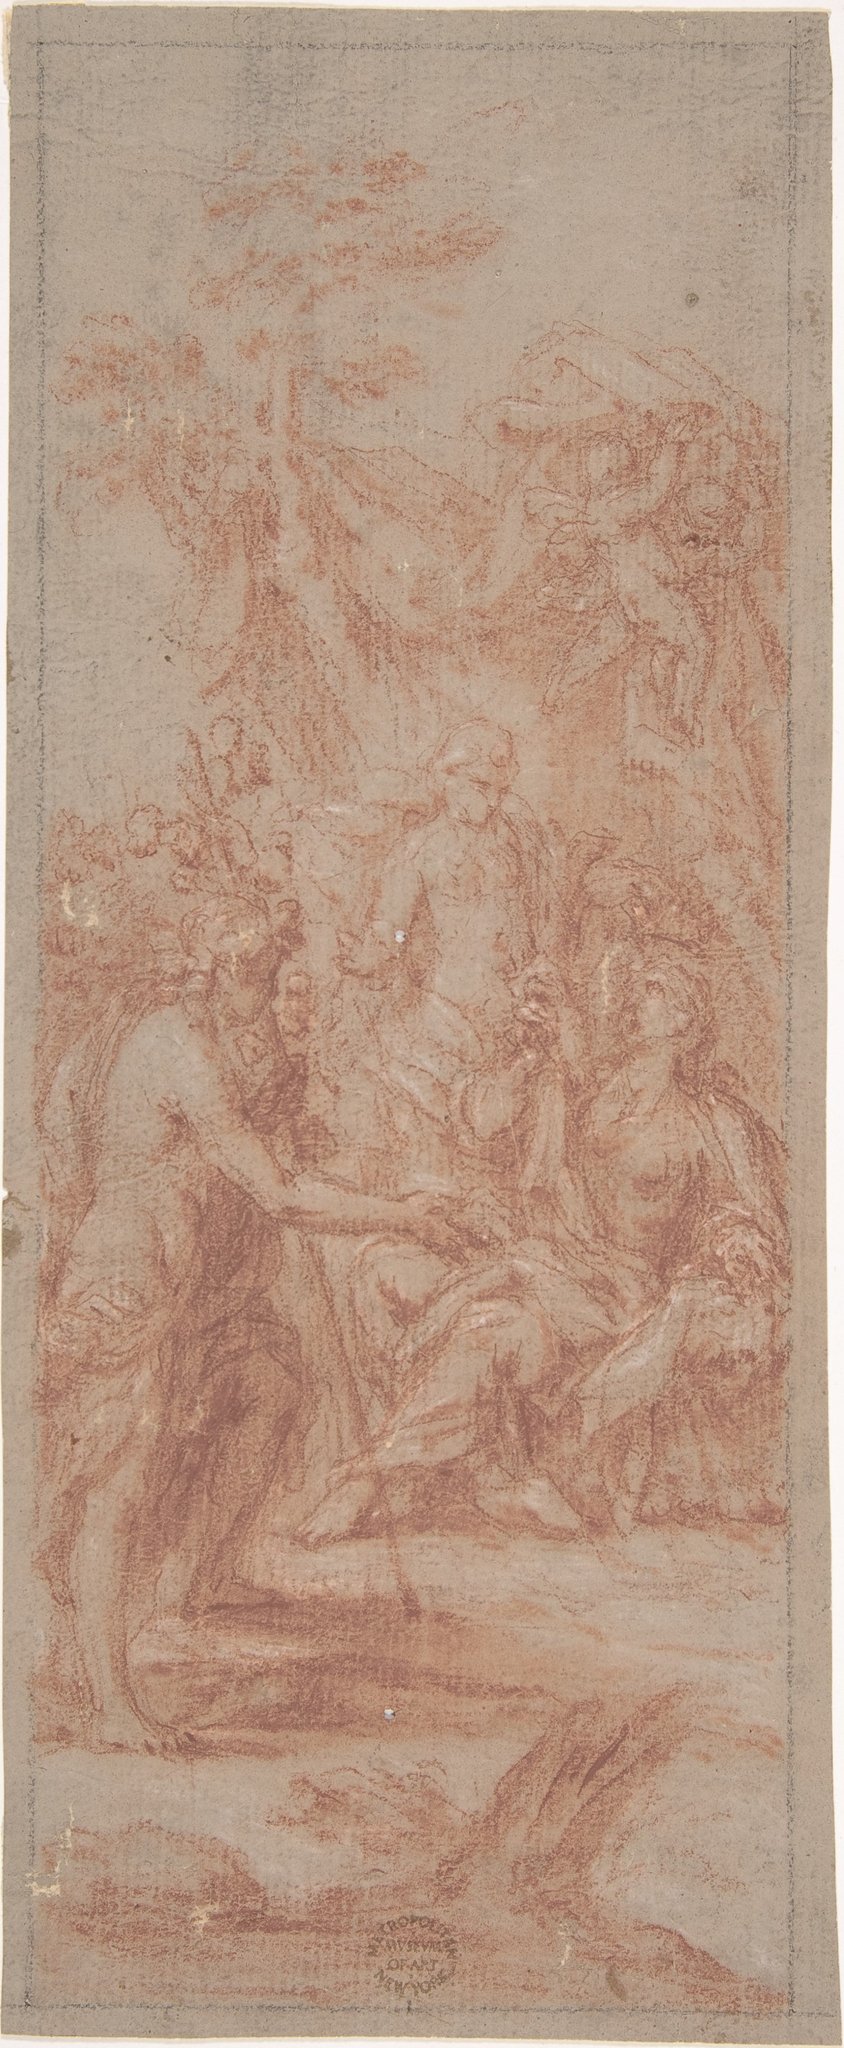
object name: drawing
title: Bacchus and Ariadne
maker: anonymous, italian, roman-bolognese, 17th century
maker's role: artist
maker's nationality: italian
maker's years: 1600-1700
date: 1601-1700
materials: chalk, paper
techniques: heightening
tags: ariadne,bacchus